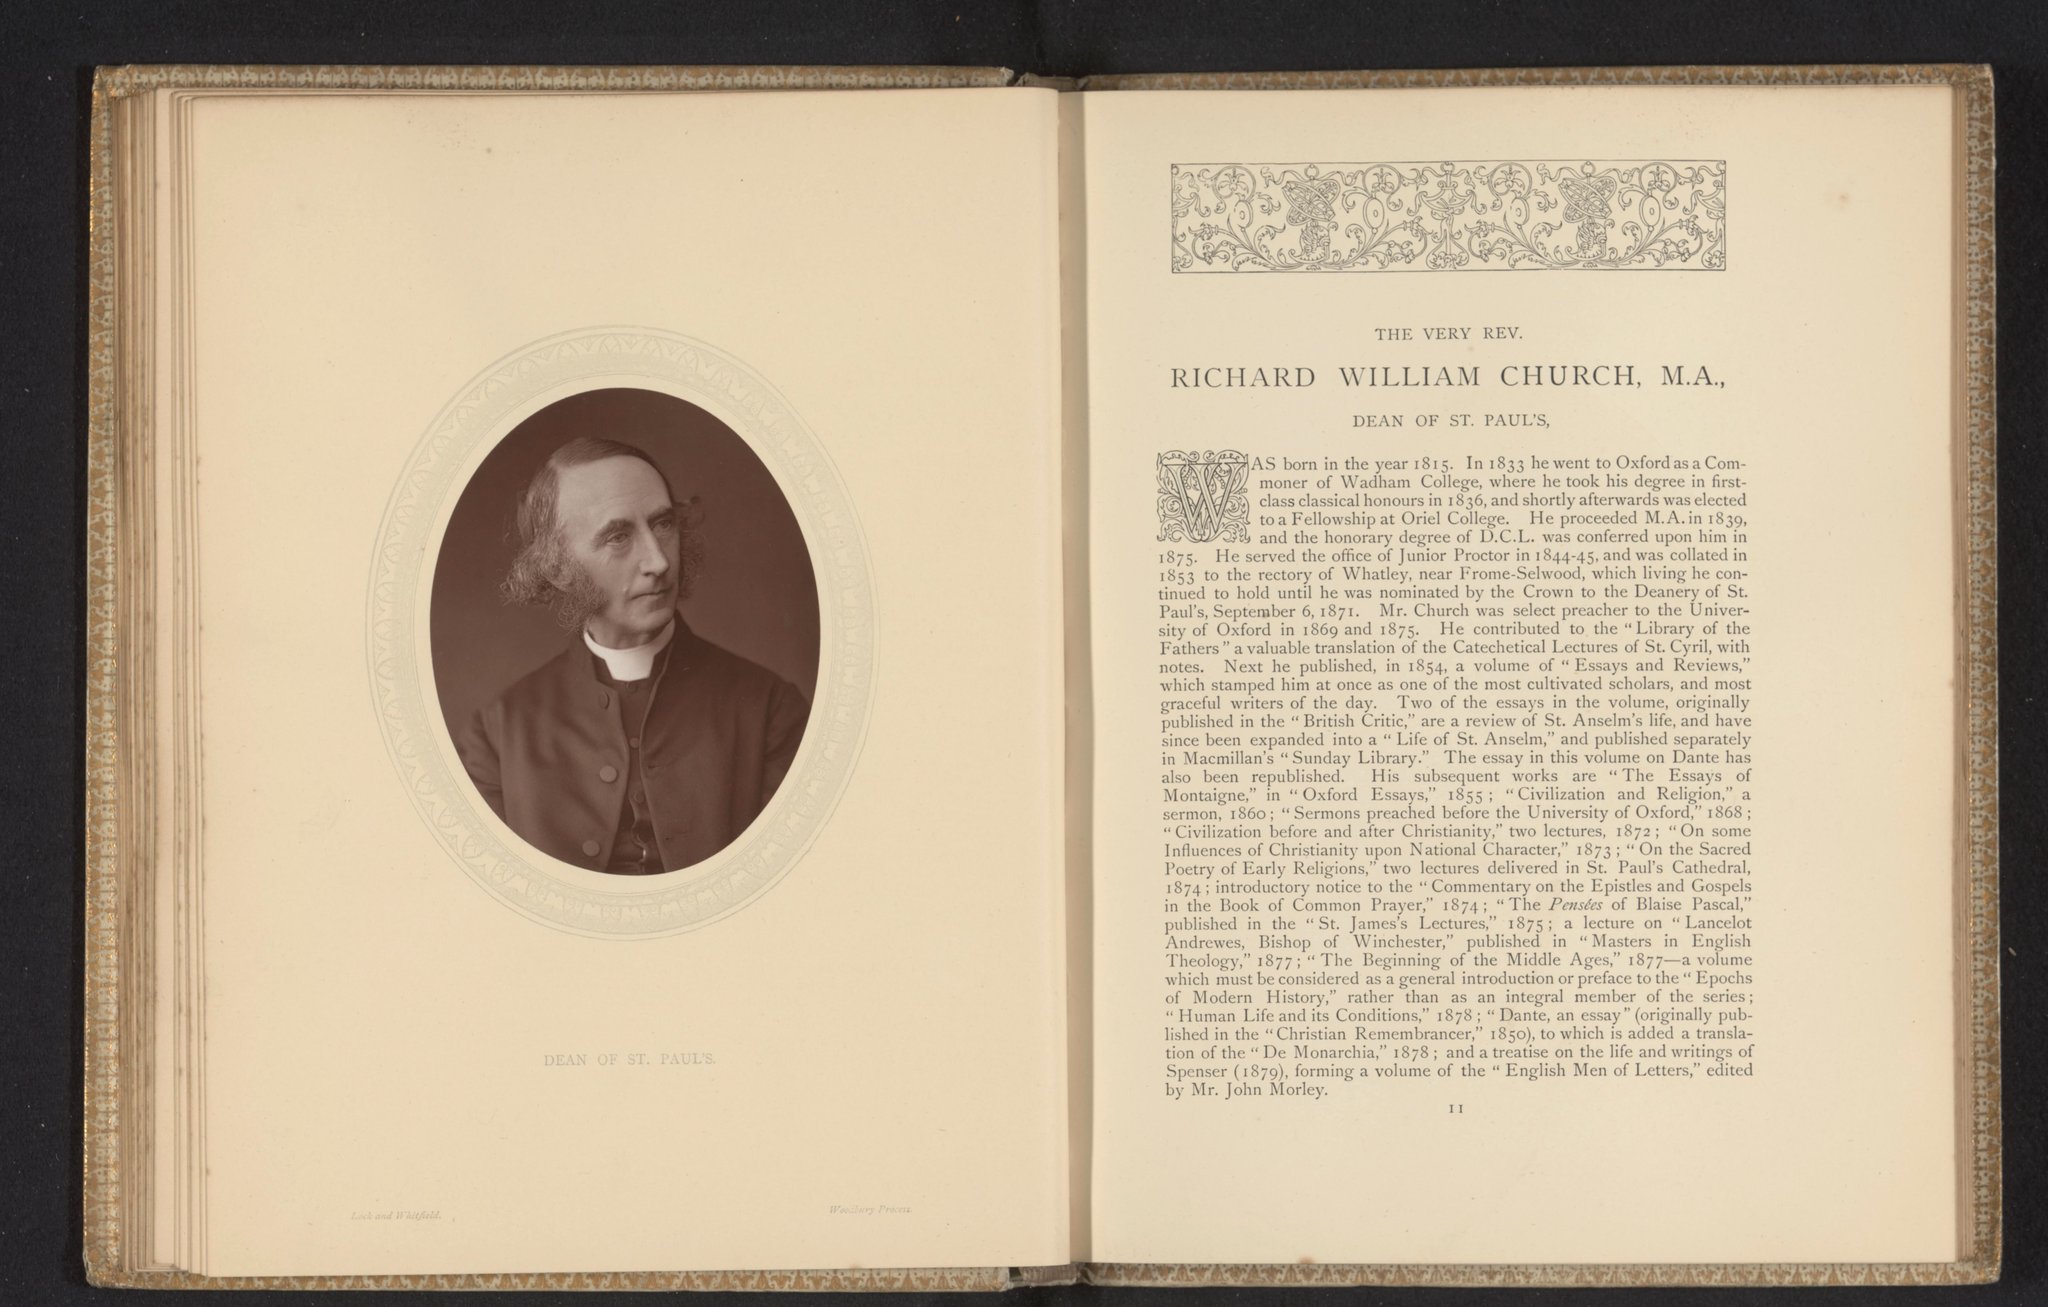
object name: photomechanical print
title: Dean of St. Paul's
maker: Anonymous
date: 1877-1882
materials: paper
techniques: woodburytype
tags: historical persons (portraits and scenes from the life) (+ (full) bust portrait), organization, functionaries and dignitaries in roman catholic church; clergy in general